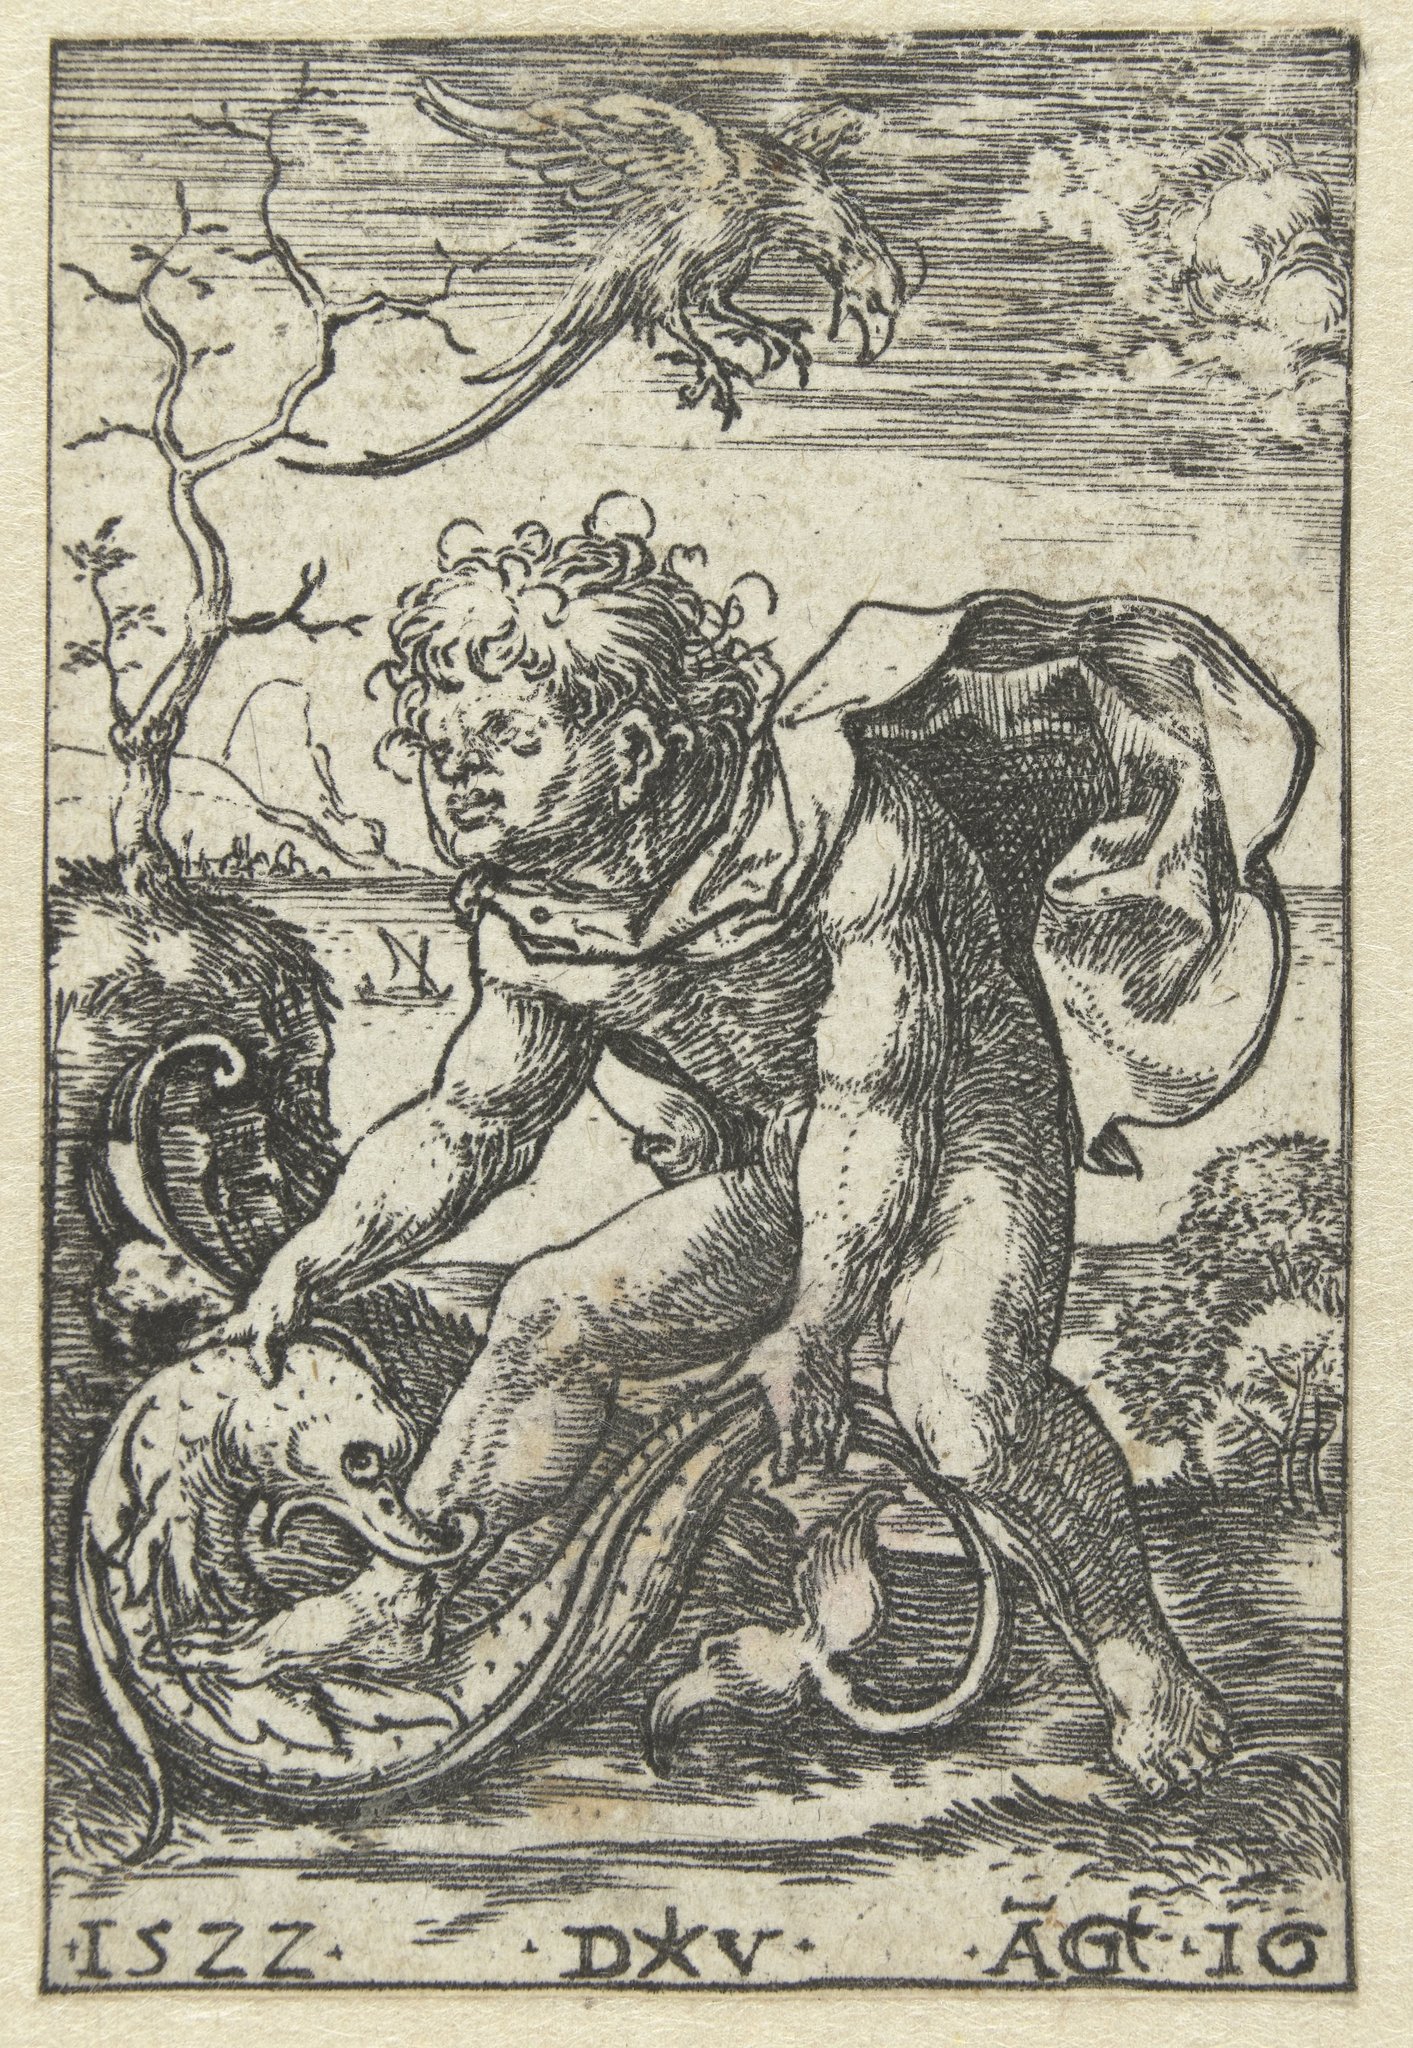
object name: print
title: Man met een vis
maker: dirck vellert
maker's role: draughtsman, painter, print maker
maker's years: 1480-1547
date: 1522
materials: paper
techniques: engraving, etching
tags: fabulous animals ~ fishes, predatory birds, male sex; man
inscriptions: collector's mark: Lugt 240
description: Man in gevecht met een vis. Roofvogel boven hem in de lucht.